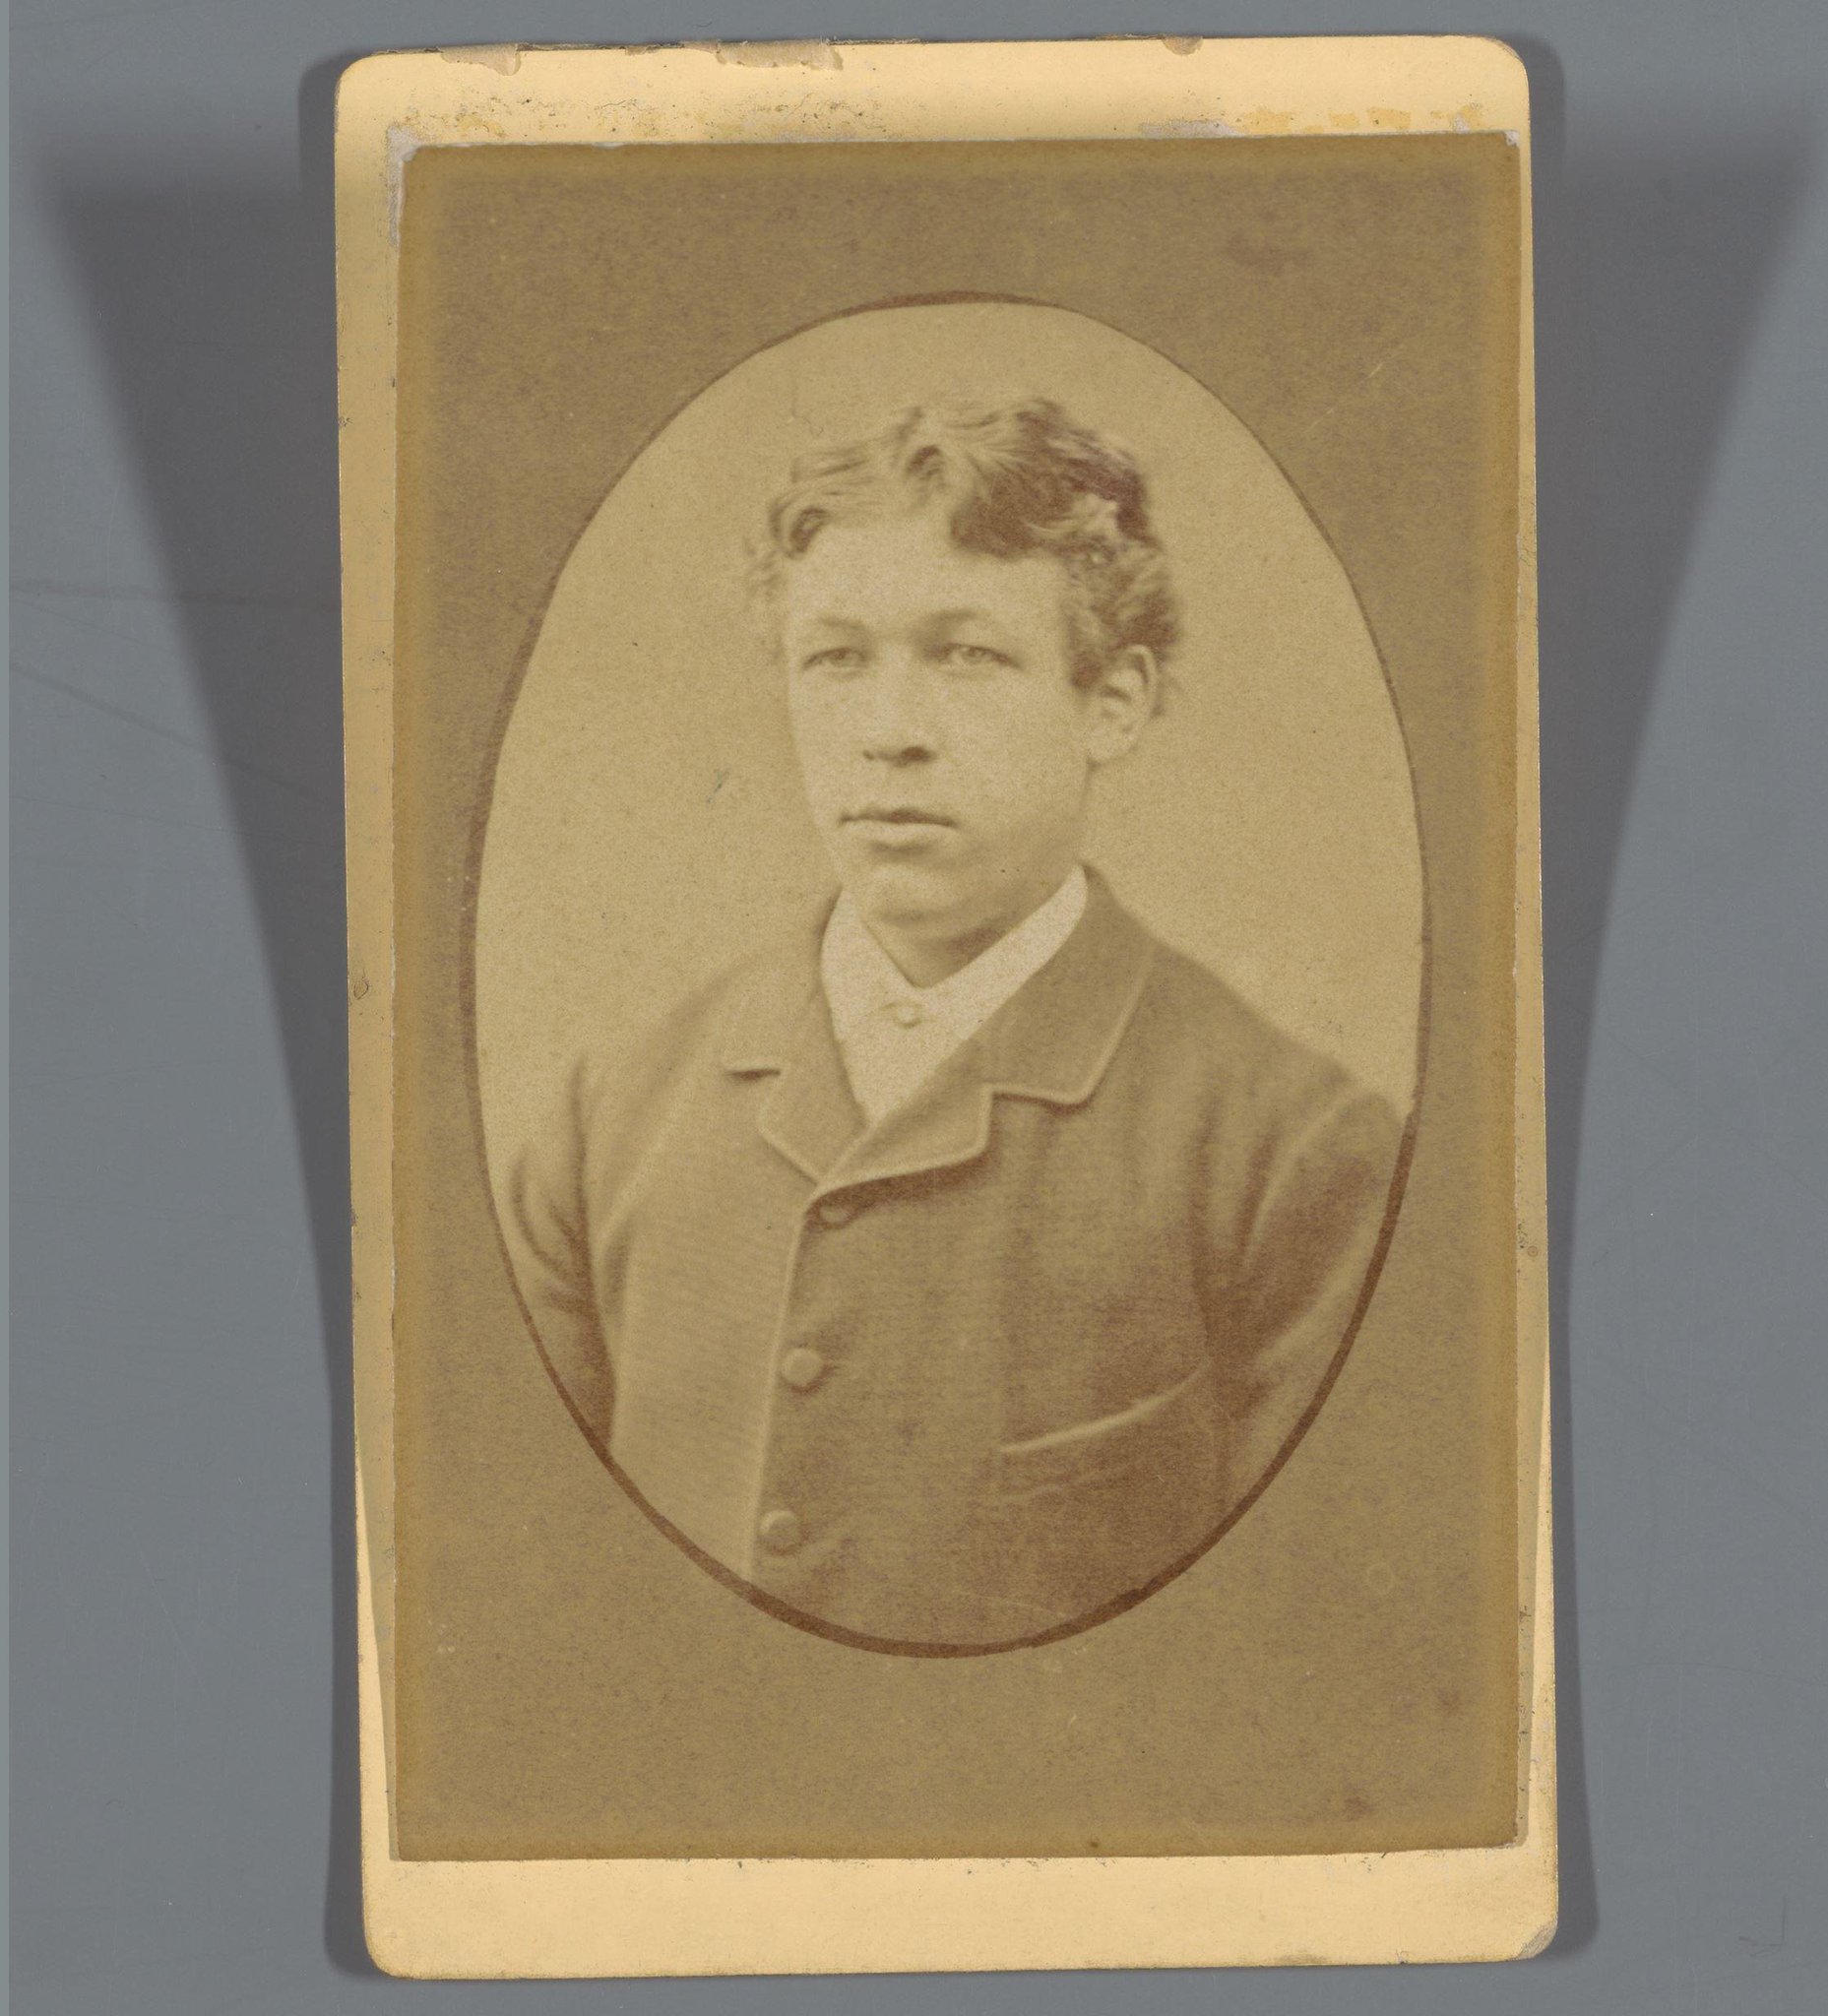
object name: photograph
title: Portret van een onbekende jongeman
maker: j.j. geels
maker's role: fotograaf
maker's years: 1833-1890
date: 1873-1884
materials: cardboard, celluloid, paper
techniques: albumen print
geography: haarlem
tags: adult man, anonymous historical person portrayed, haarlem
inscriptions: inscription: ‘Photographie/ van/ J.J. Geels./ Nieuwe gracht No. 12,/ Haarlem./ Fijn afgewerkte Salonportretten, Vergrootingen/ en Reproductie to zeer lage prijzen.’